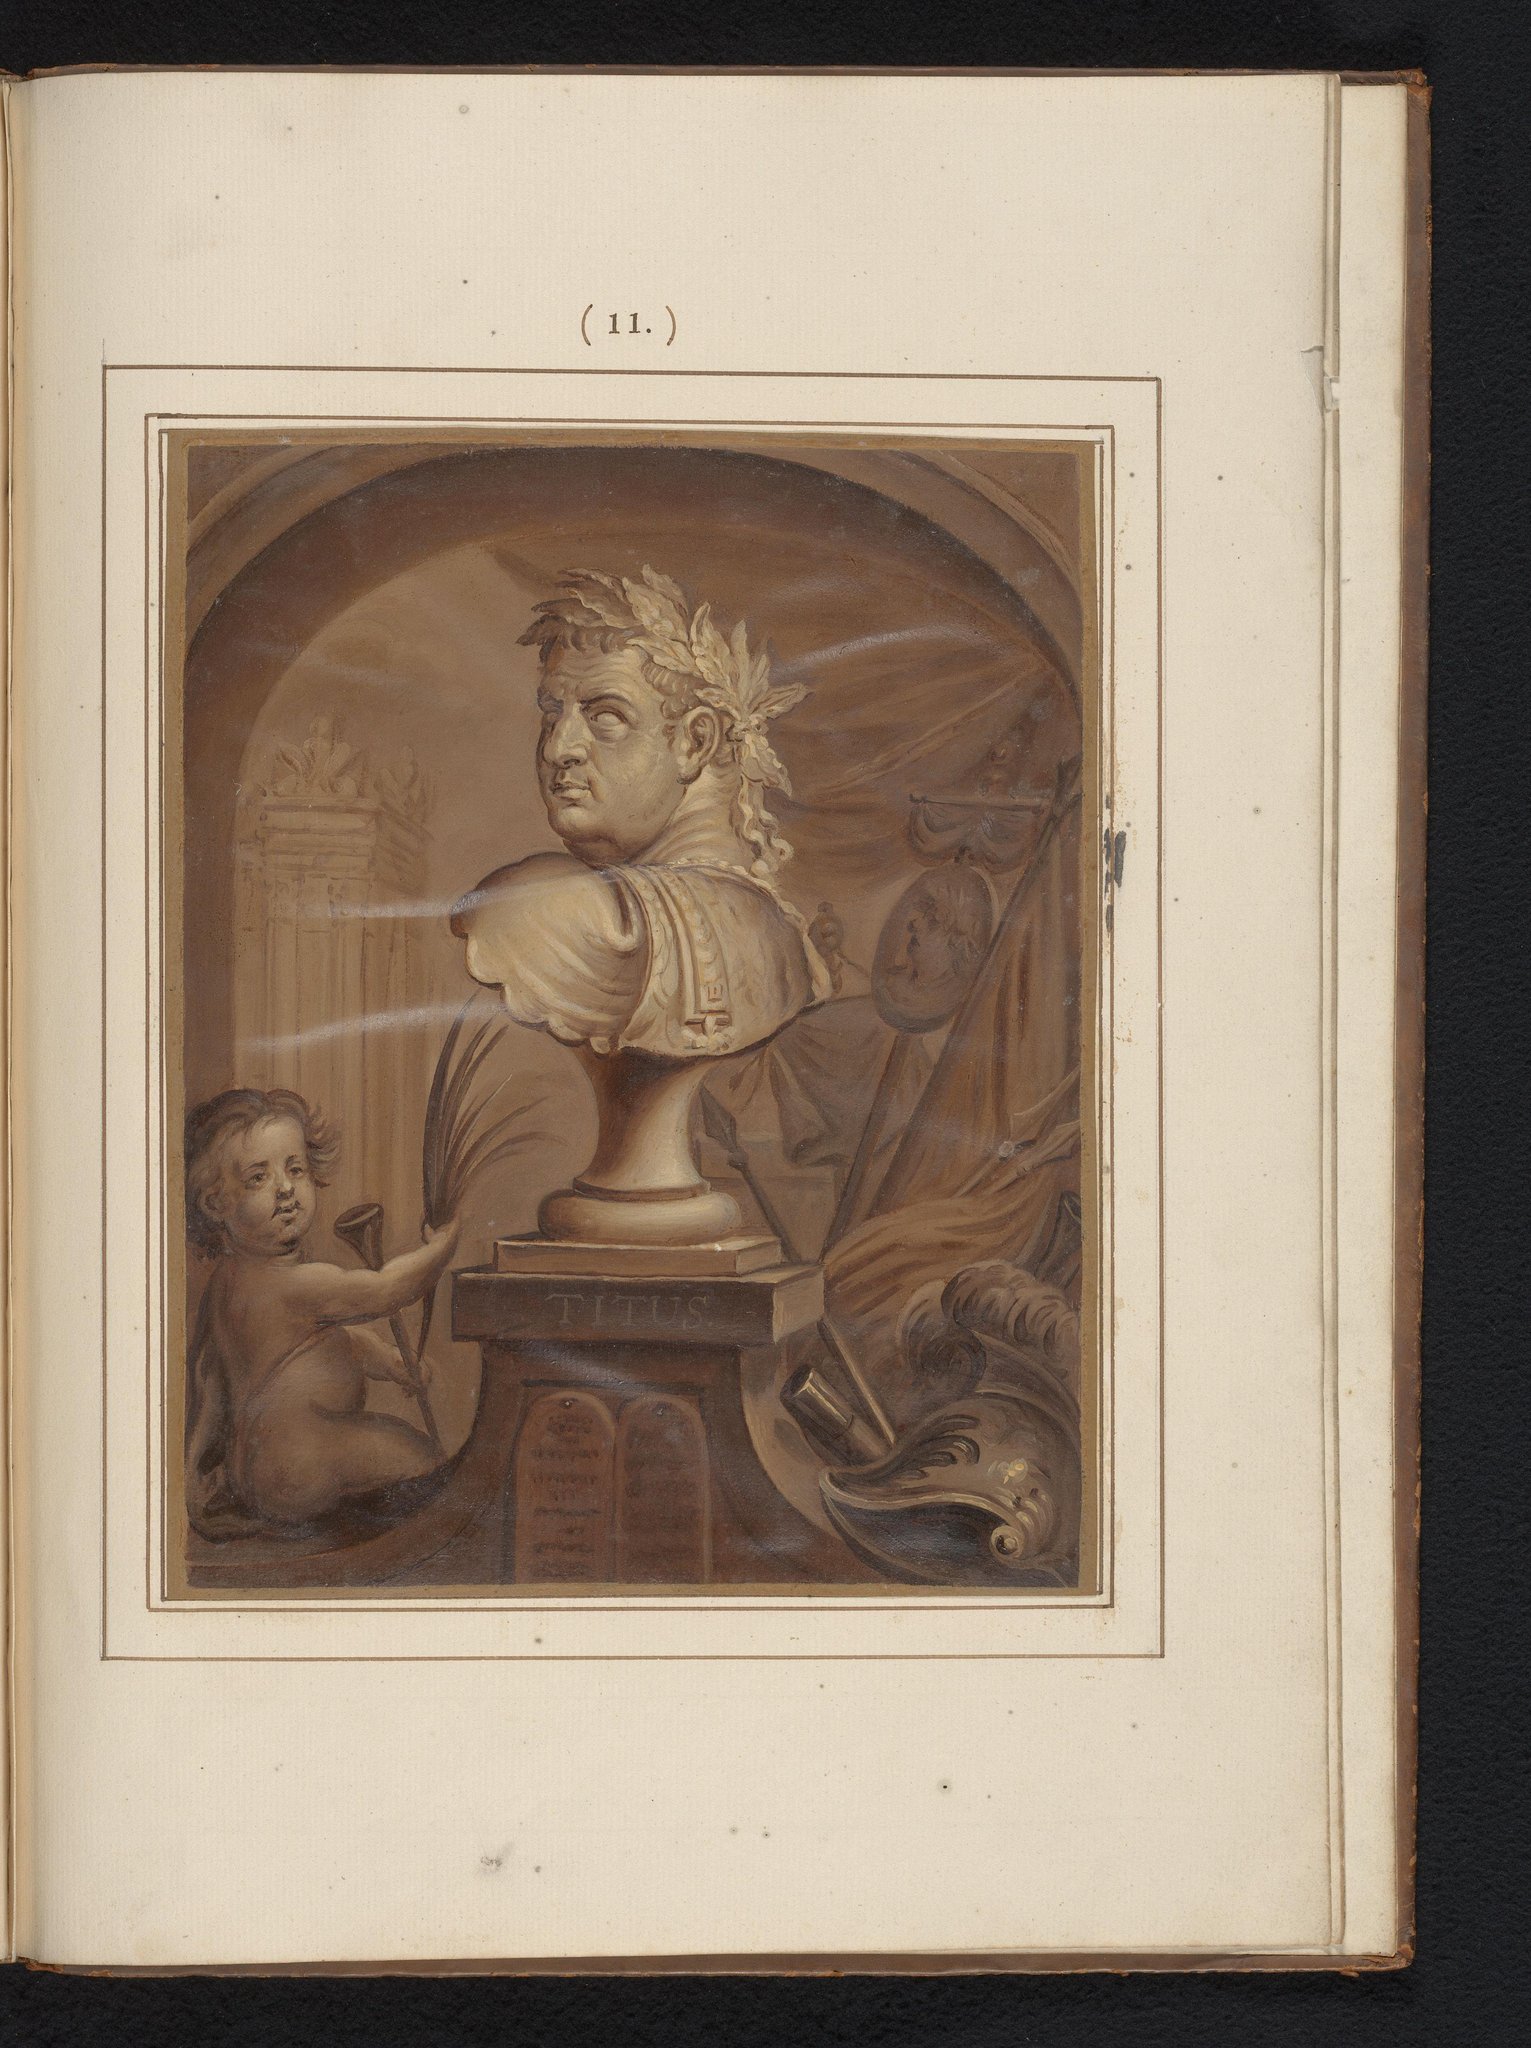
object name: drawing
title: Portret van keizer Titus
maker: pieter anthony wakkerdak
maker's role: print maker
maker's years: 1729-1774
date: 1773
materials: paint, paper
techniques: brush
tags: rome, historical persons, emperor, crowning with laurel, cupids: 'amores', 'amoretti', 'putti'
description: Tekening maakt deel uit van een manuscript.